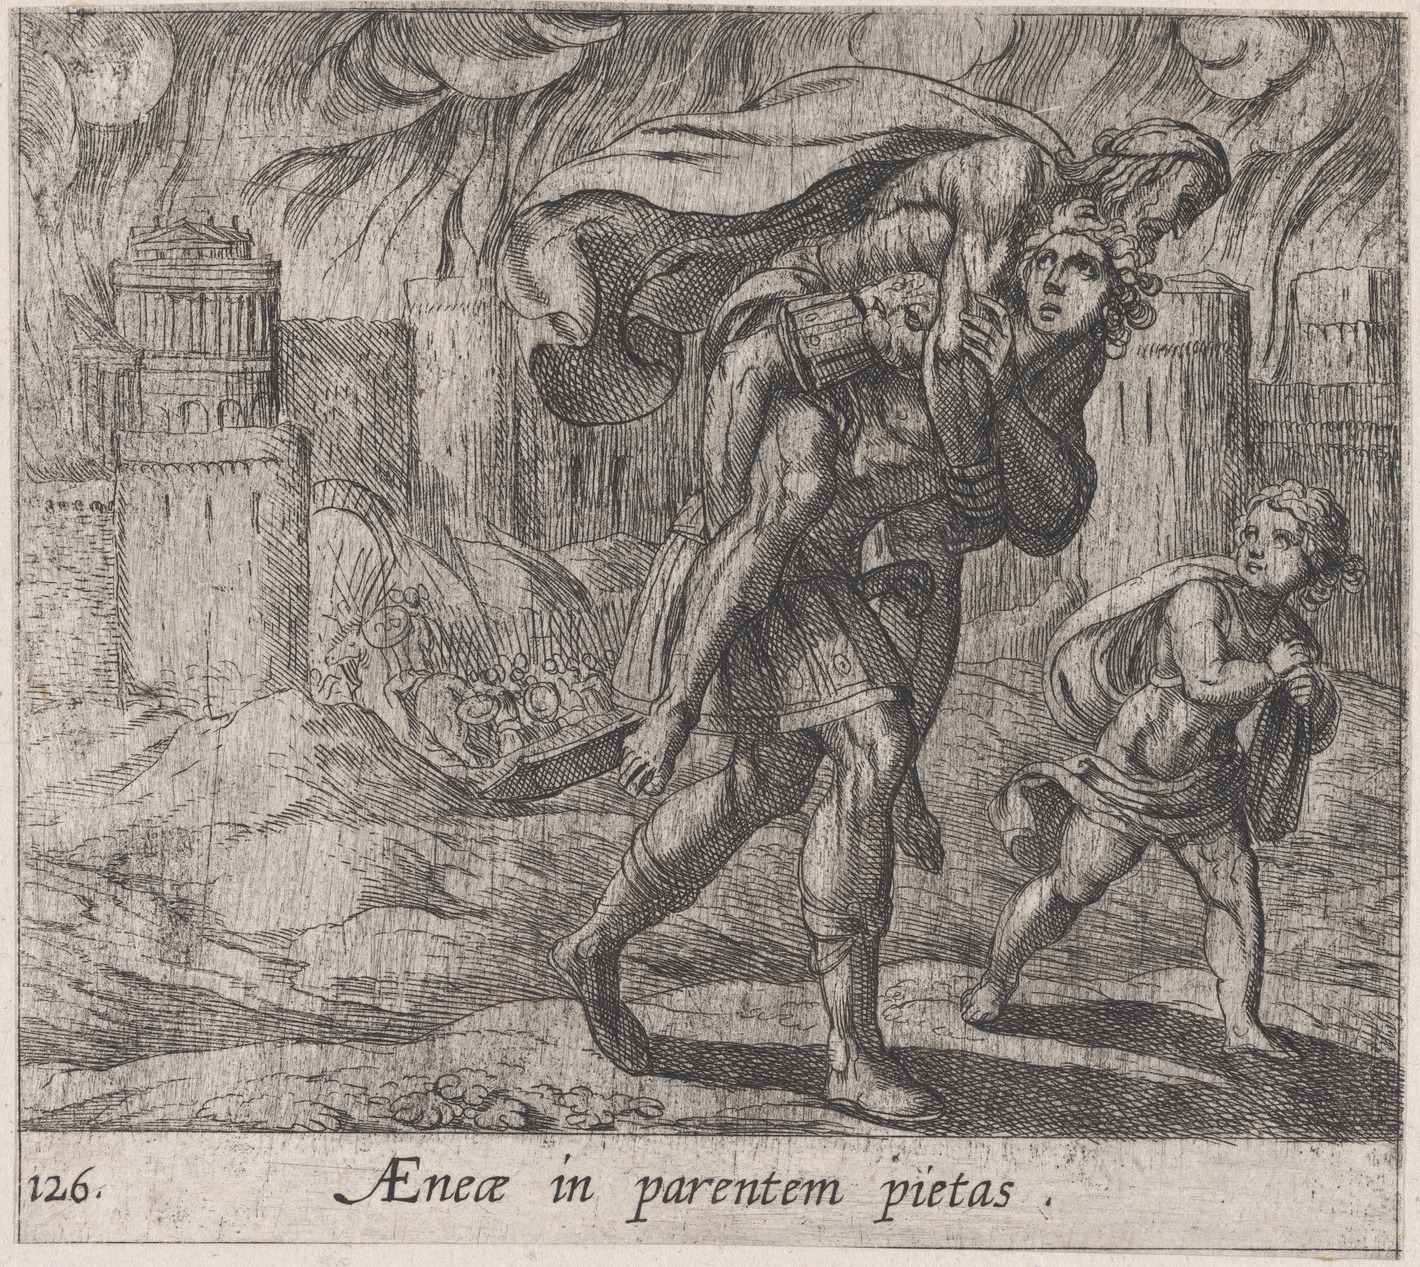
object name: print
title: Plate 126: Aeneas and Anchises (AEnea in perentem pietas), from Ovid's 'Metamorphoses'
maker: antonio tempesta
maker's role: artist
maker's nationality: italian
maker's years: 1555-1630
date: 1606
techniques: etching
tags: aeneas